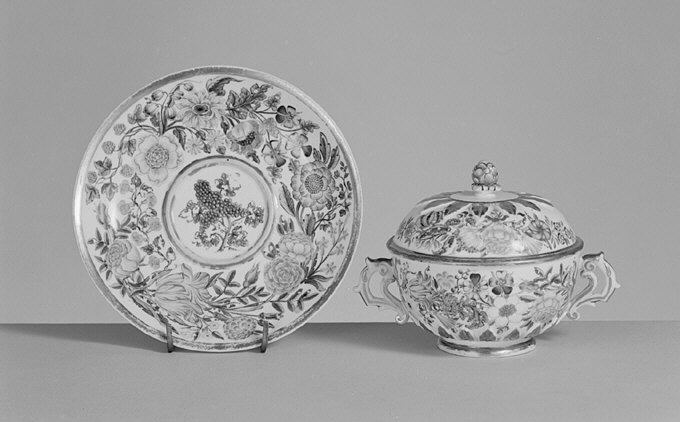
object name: écuelle with cover and stand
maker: meissen manufactory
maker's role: manufactory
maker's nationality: german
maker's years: 1710-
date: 1739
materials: hard paste porcelain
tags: fruit,flowers